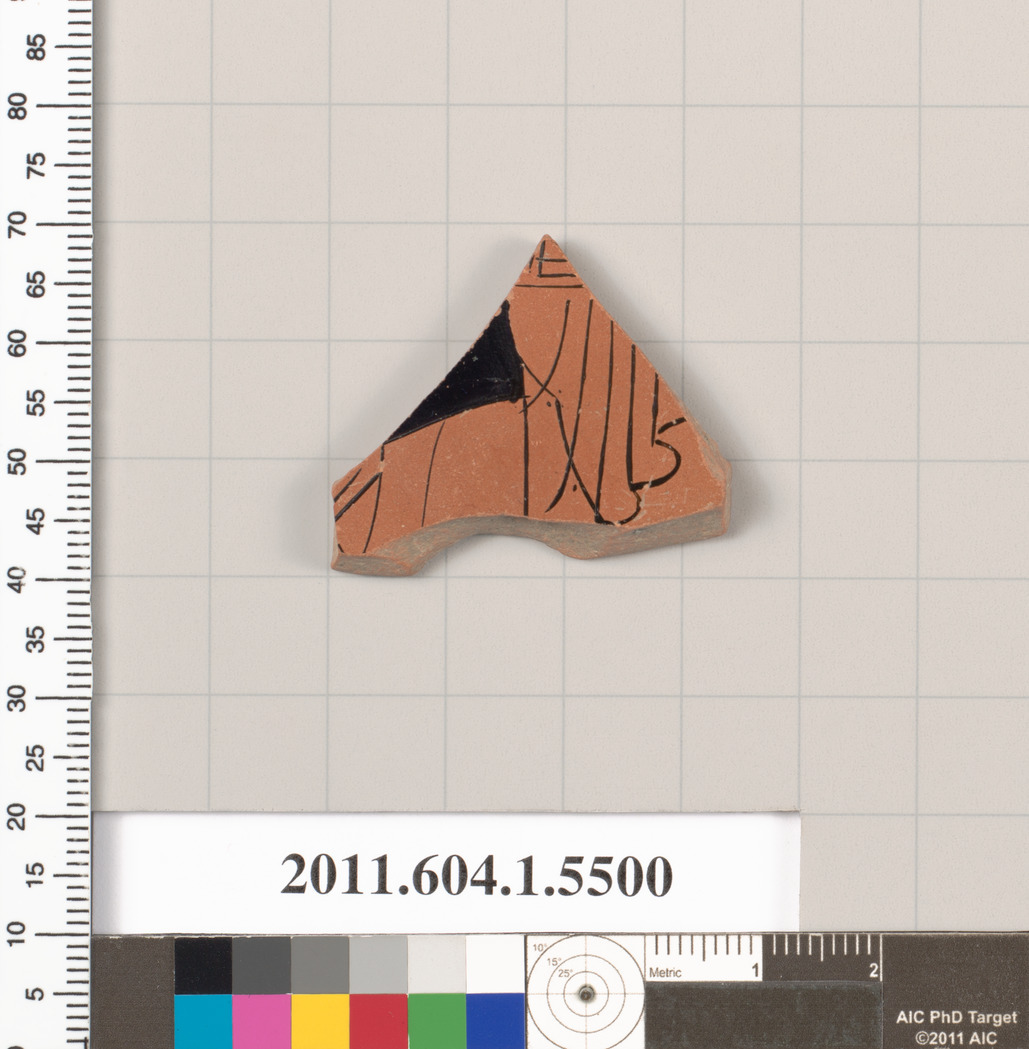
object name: kylix fragment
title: Terracotta fragment of a kylix (drinking cup)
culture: greek, attic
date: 500-480 BCE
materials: terracotta